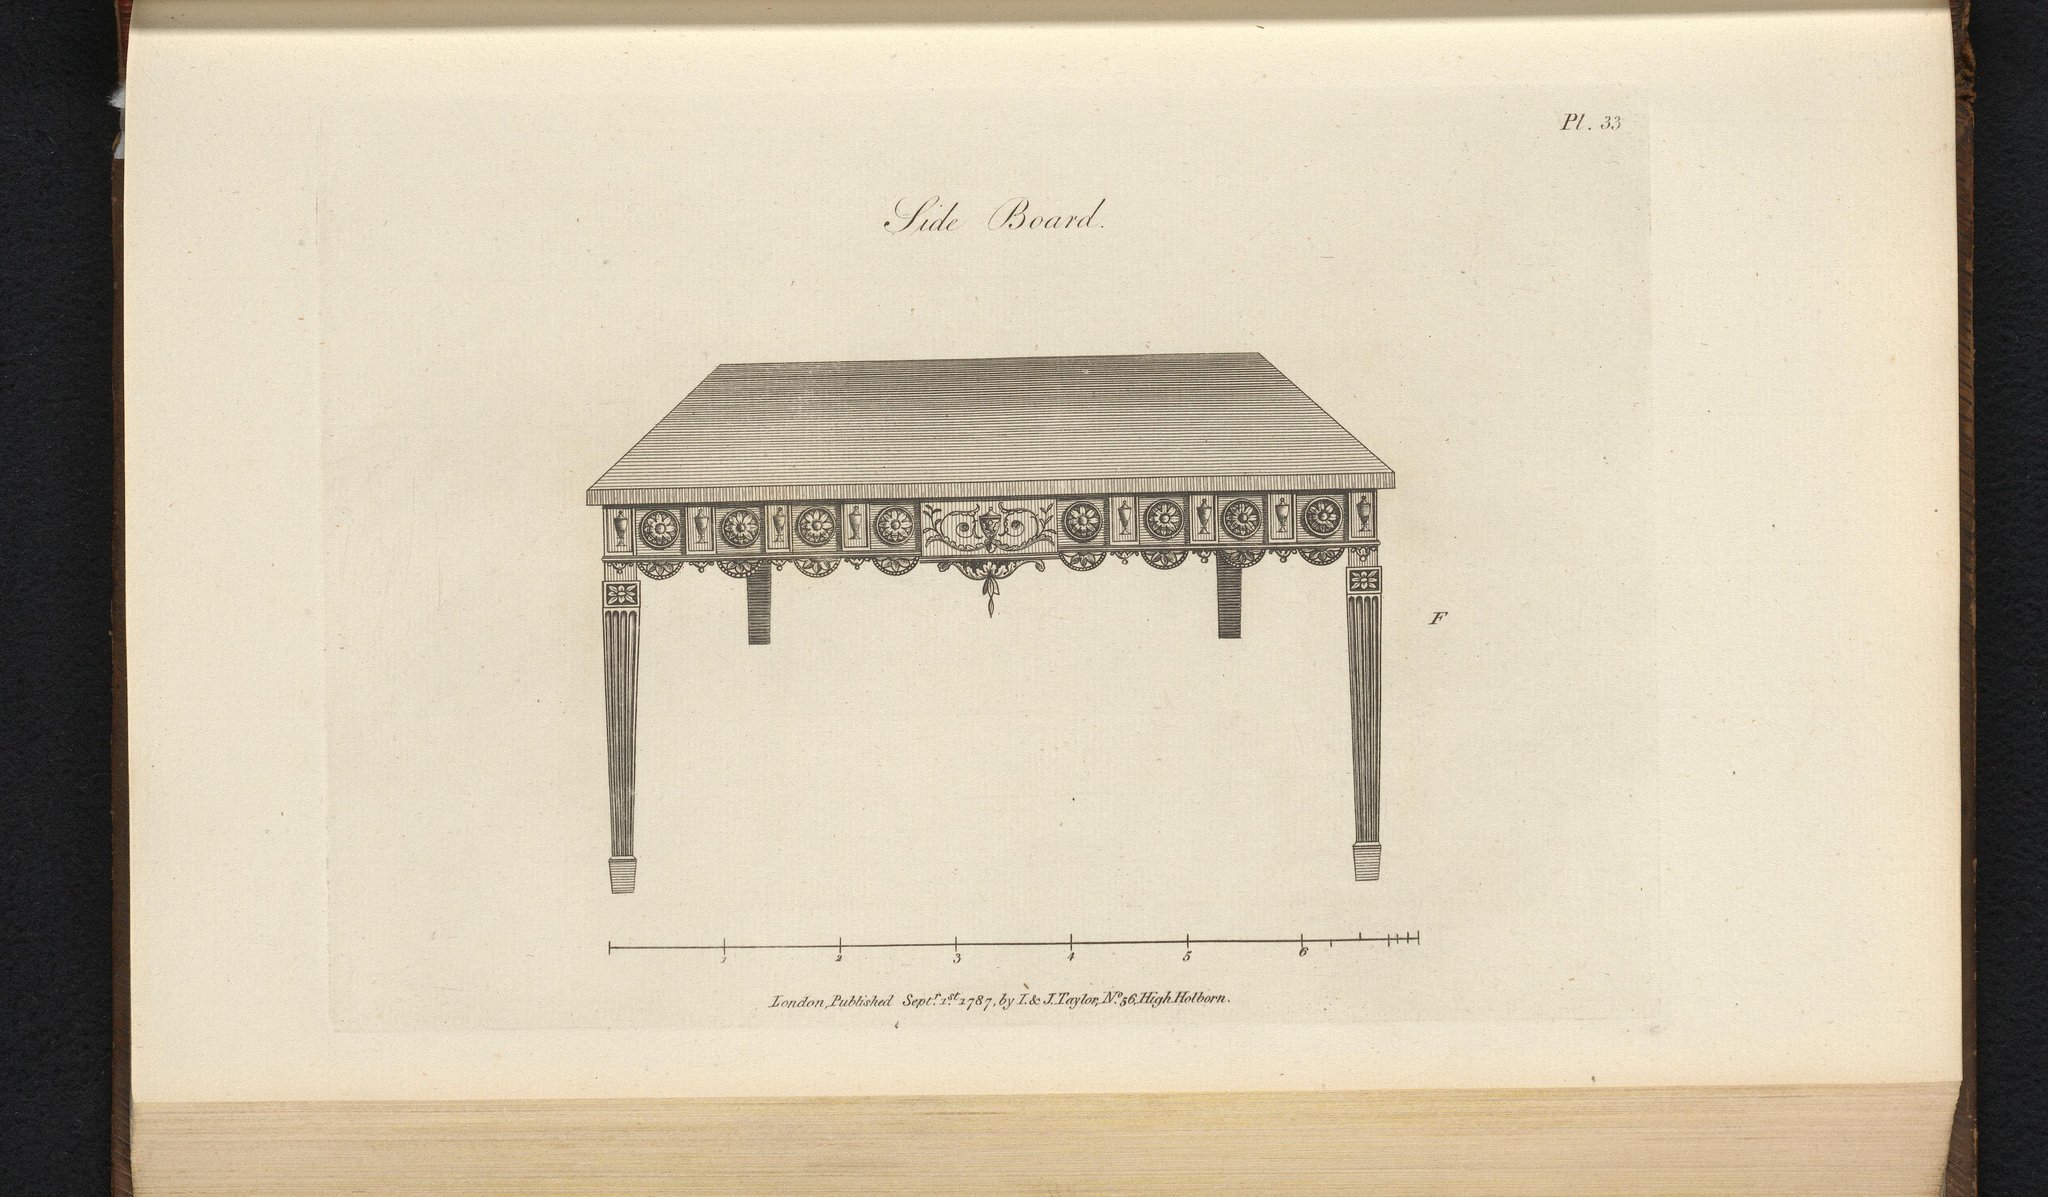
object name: print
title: Meubels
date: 1787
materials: paper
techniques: engraving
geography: holborn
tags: writing-table, writing-desk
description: Genummerd: Pl. 33. Tafel gemerkt: F. Schaalverdeling in de ondermarge. Prent maakt deel uit van een boek.